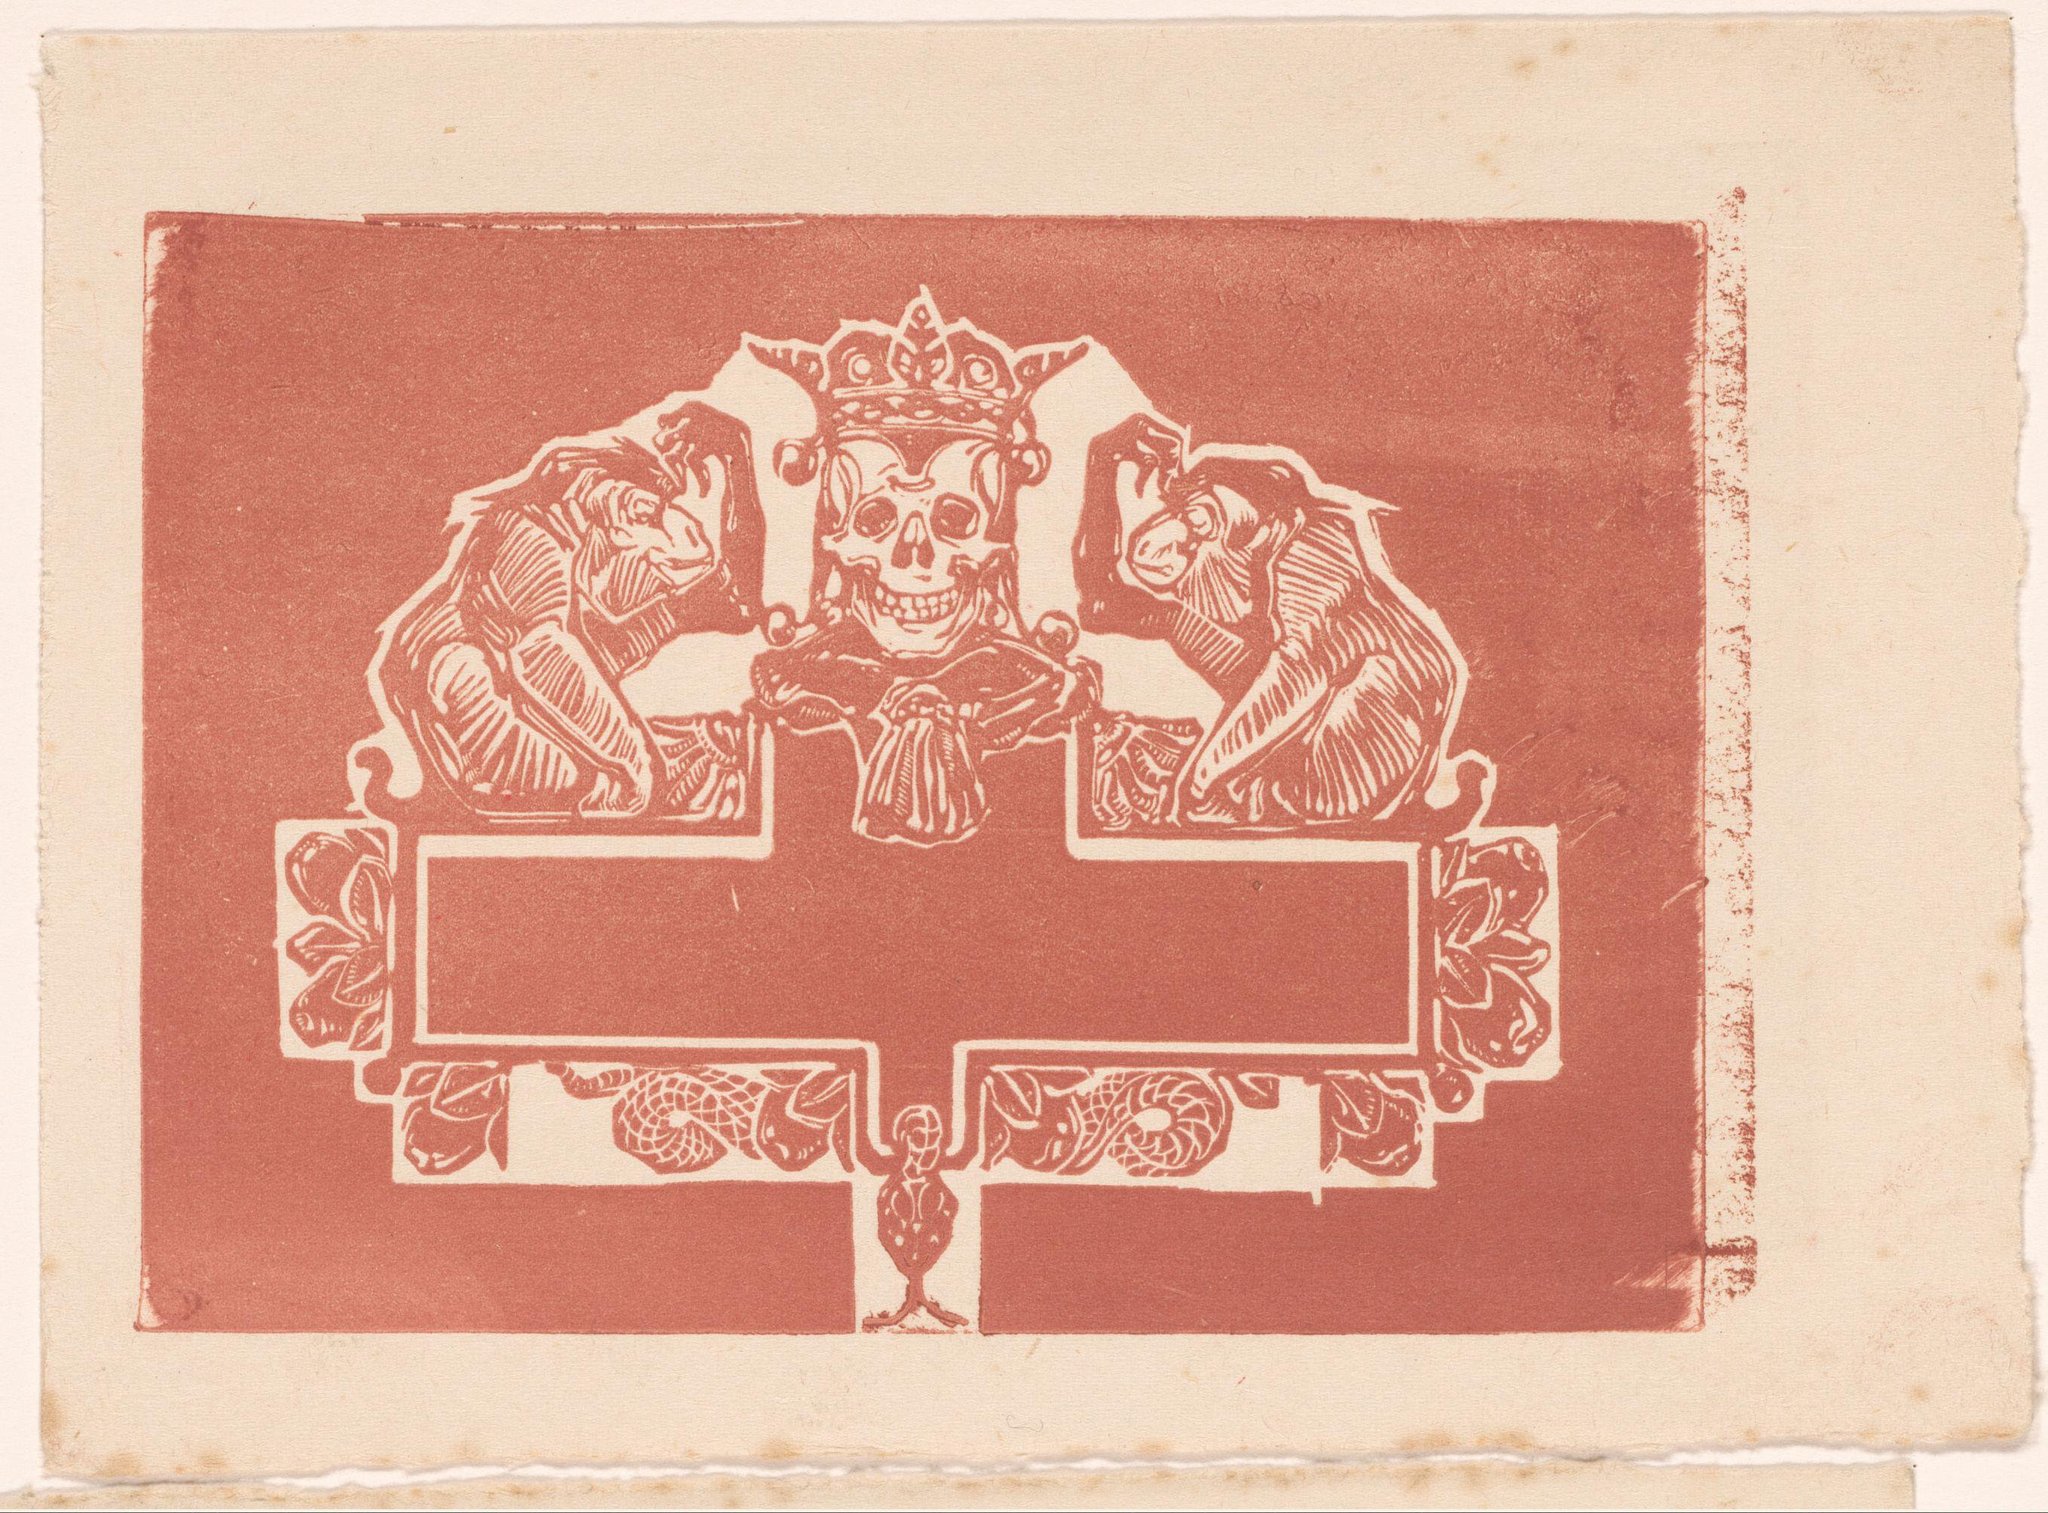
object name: boekillustratie ontwerp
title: Titelvignet met gekroond schedel en apen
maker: bernard willem wierink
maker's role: draughtsman, print maker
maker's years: 1856-1939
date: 1910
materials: paper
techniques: relief print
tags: (human) skull, monkeys, apes, fable of reynard the fox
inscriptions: collector's mark: Lugt 2228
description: Ontwerp voor: Streuvels, Stijn (Frank Lateur). Reinaert de Vos naar verschillende uitgaven van het middeleeuwsche epos. Amsterdam: L.J. Veen, 1910. Deze prent is vermoedelijk een plaatsnede, ook al wordt in de literatuur veelal gesproken over een houtsnede. Voor zover Wierink zijn prenten in hoogdruk zelf nader heeft omschreven, heeft hij altijd de term 'plaatsnede' gebruikt.